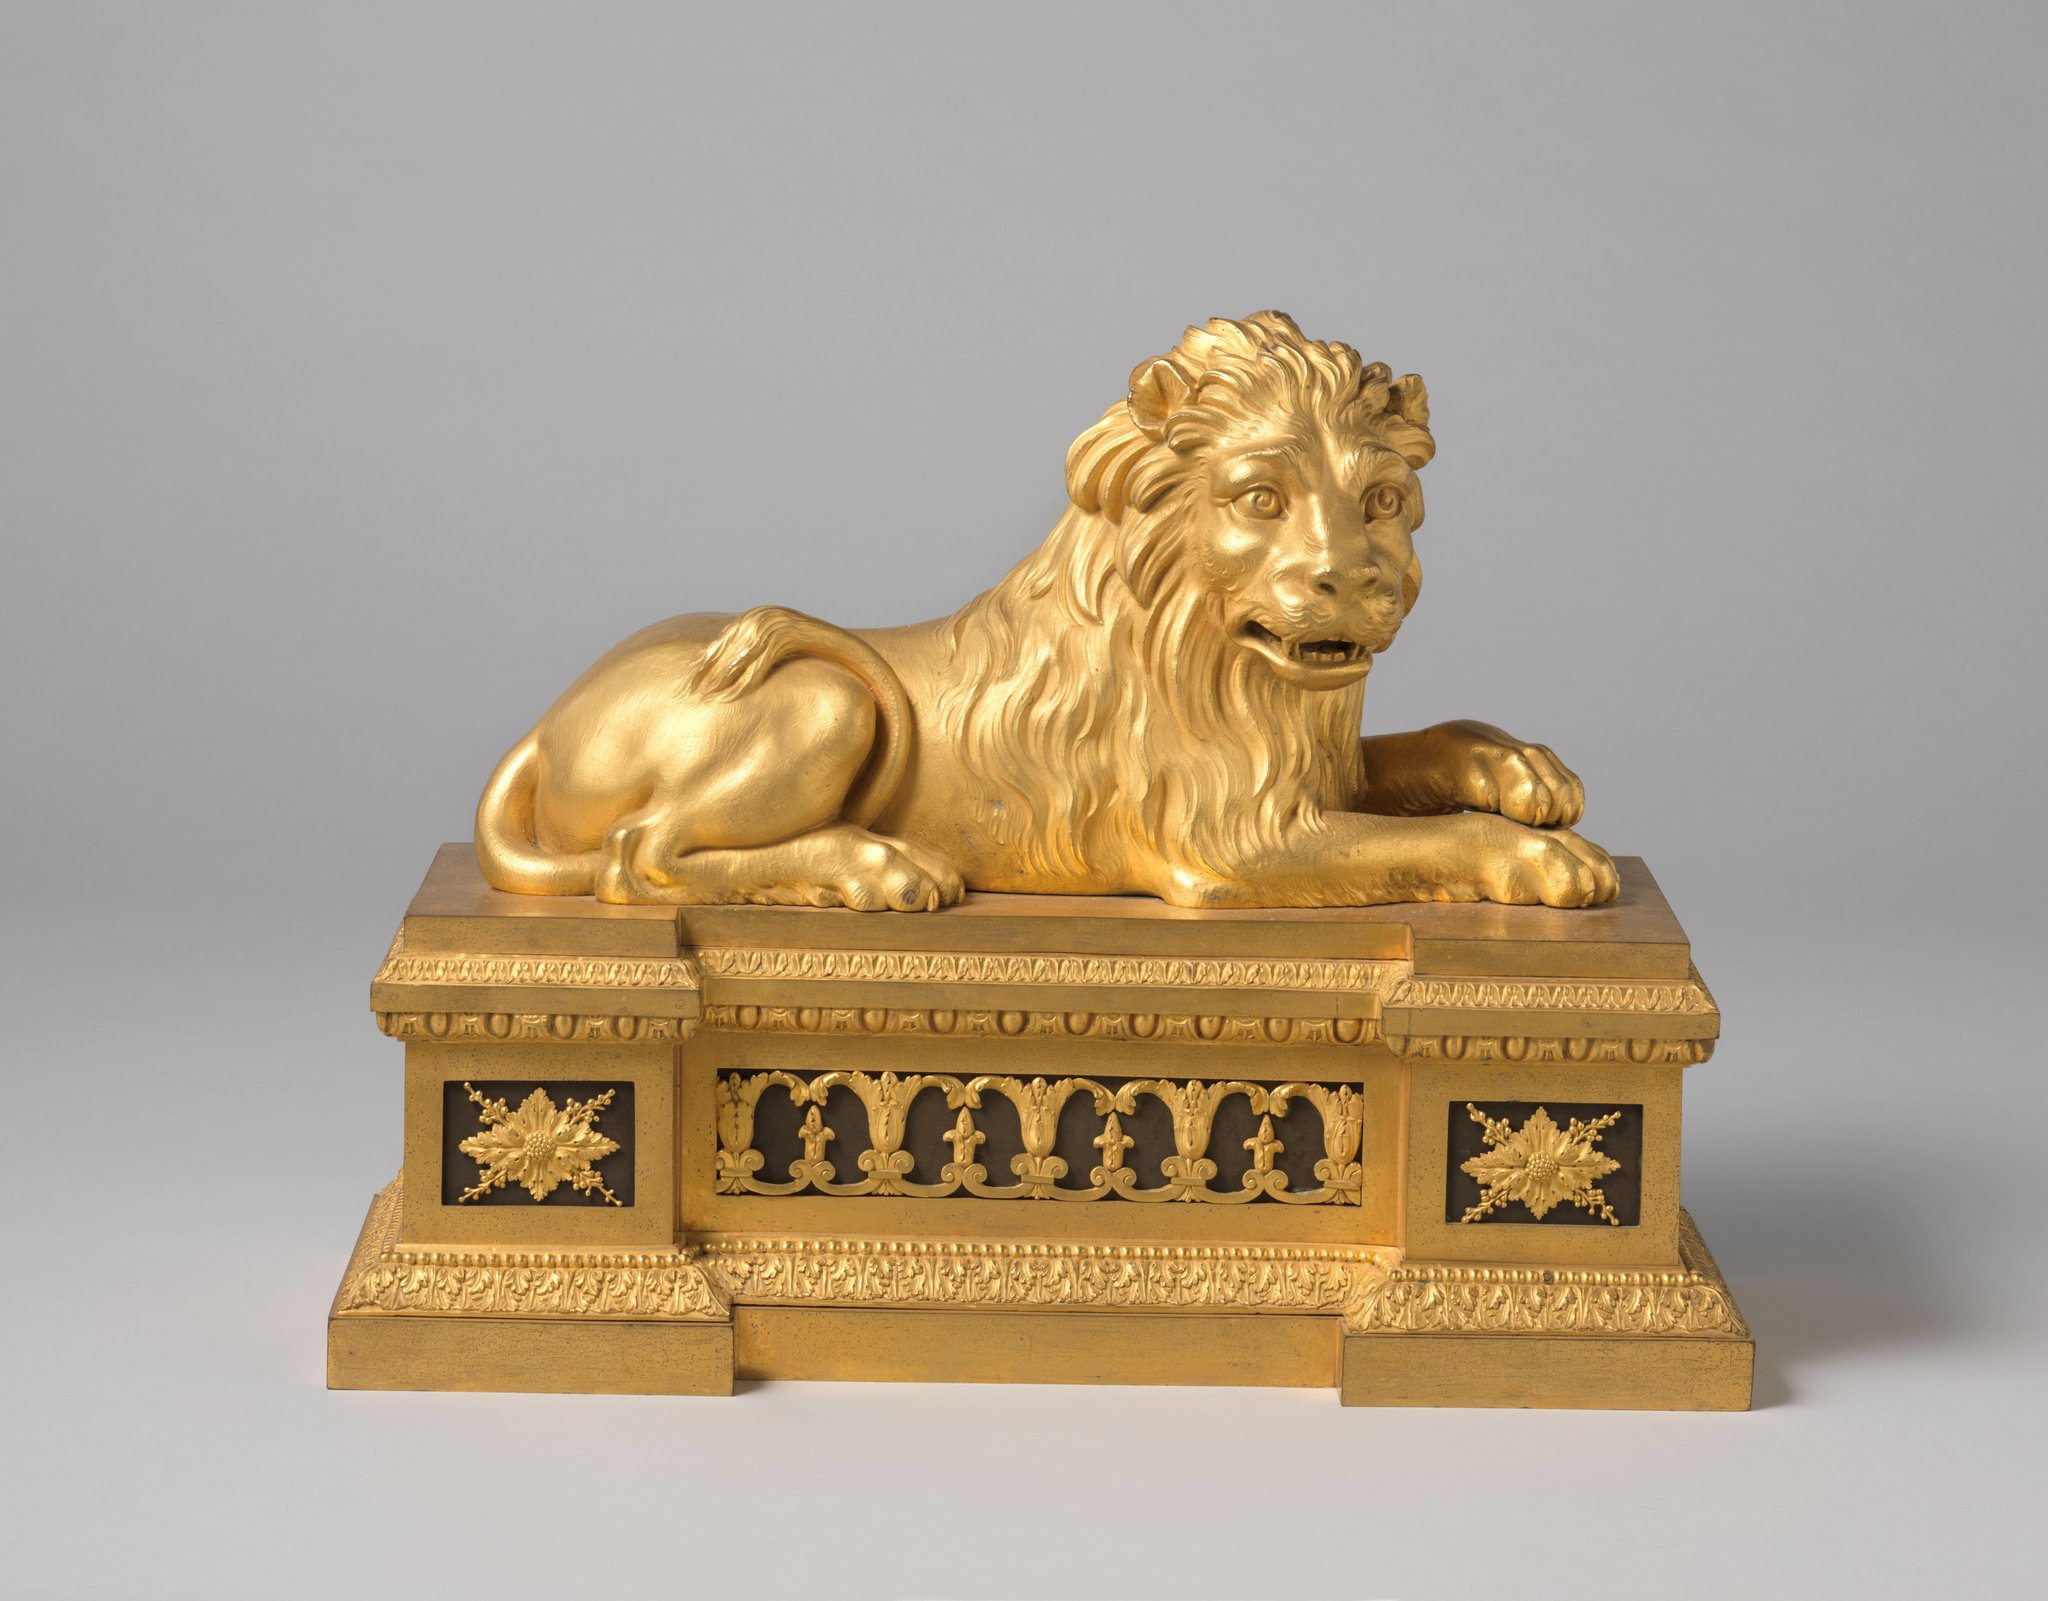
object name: vuurbok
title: Vuurbok van verguld brons in de vorm van een liggende leeuw op een basement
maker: Anonymous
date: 1800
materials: bronze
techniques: gilding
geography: france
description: Bed. Mahogany and other woods, partly gilded, gilt bronze mounts. Netherlands, c. 1808. From Paviljoen Welgelegen in Haarlem. Probably supplied to King Louis Napoleon while in residence there. Two firedogs. Gilt bronze. Paris, c. 1800. Two candelabra. Gilt and patinated bronze. Paris, c. 1800, by Pierre Philippe Thomire. Presented by the staff of the Rijksmuseum on the 50th anniversary of the museum building, 1935.